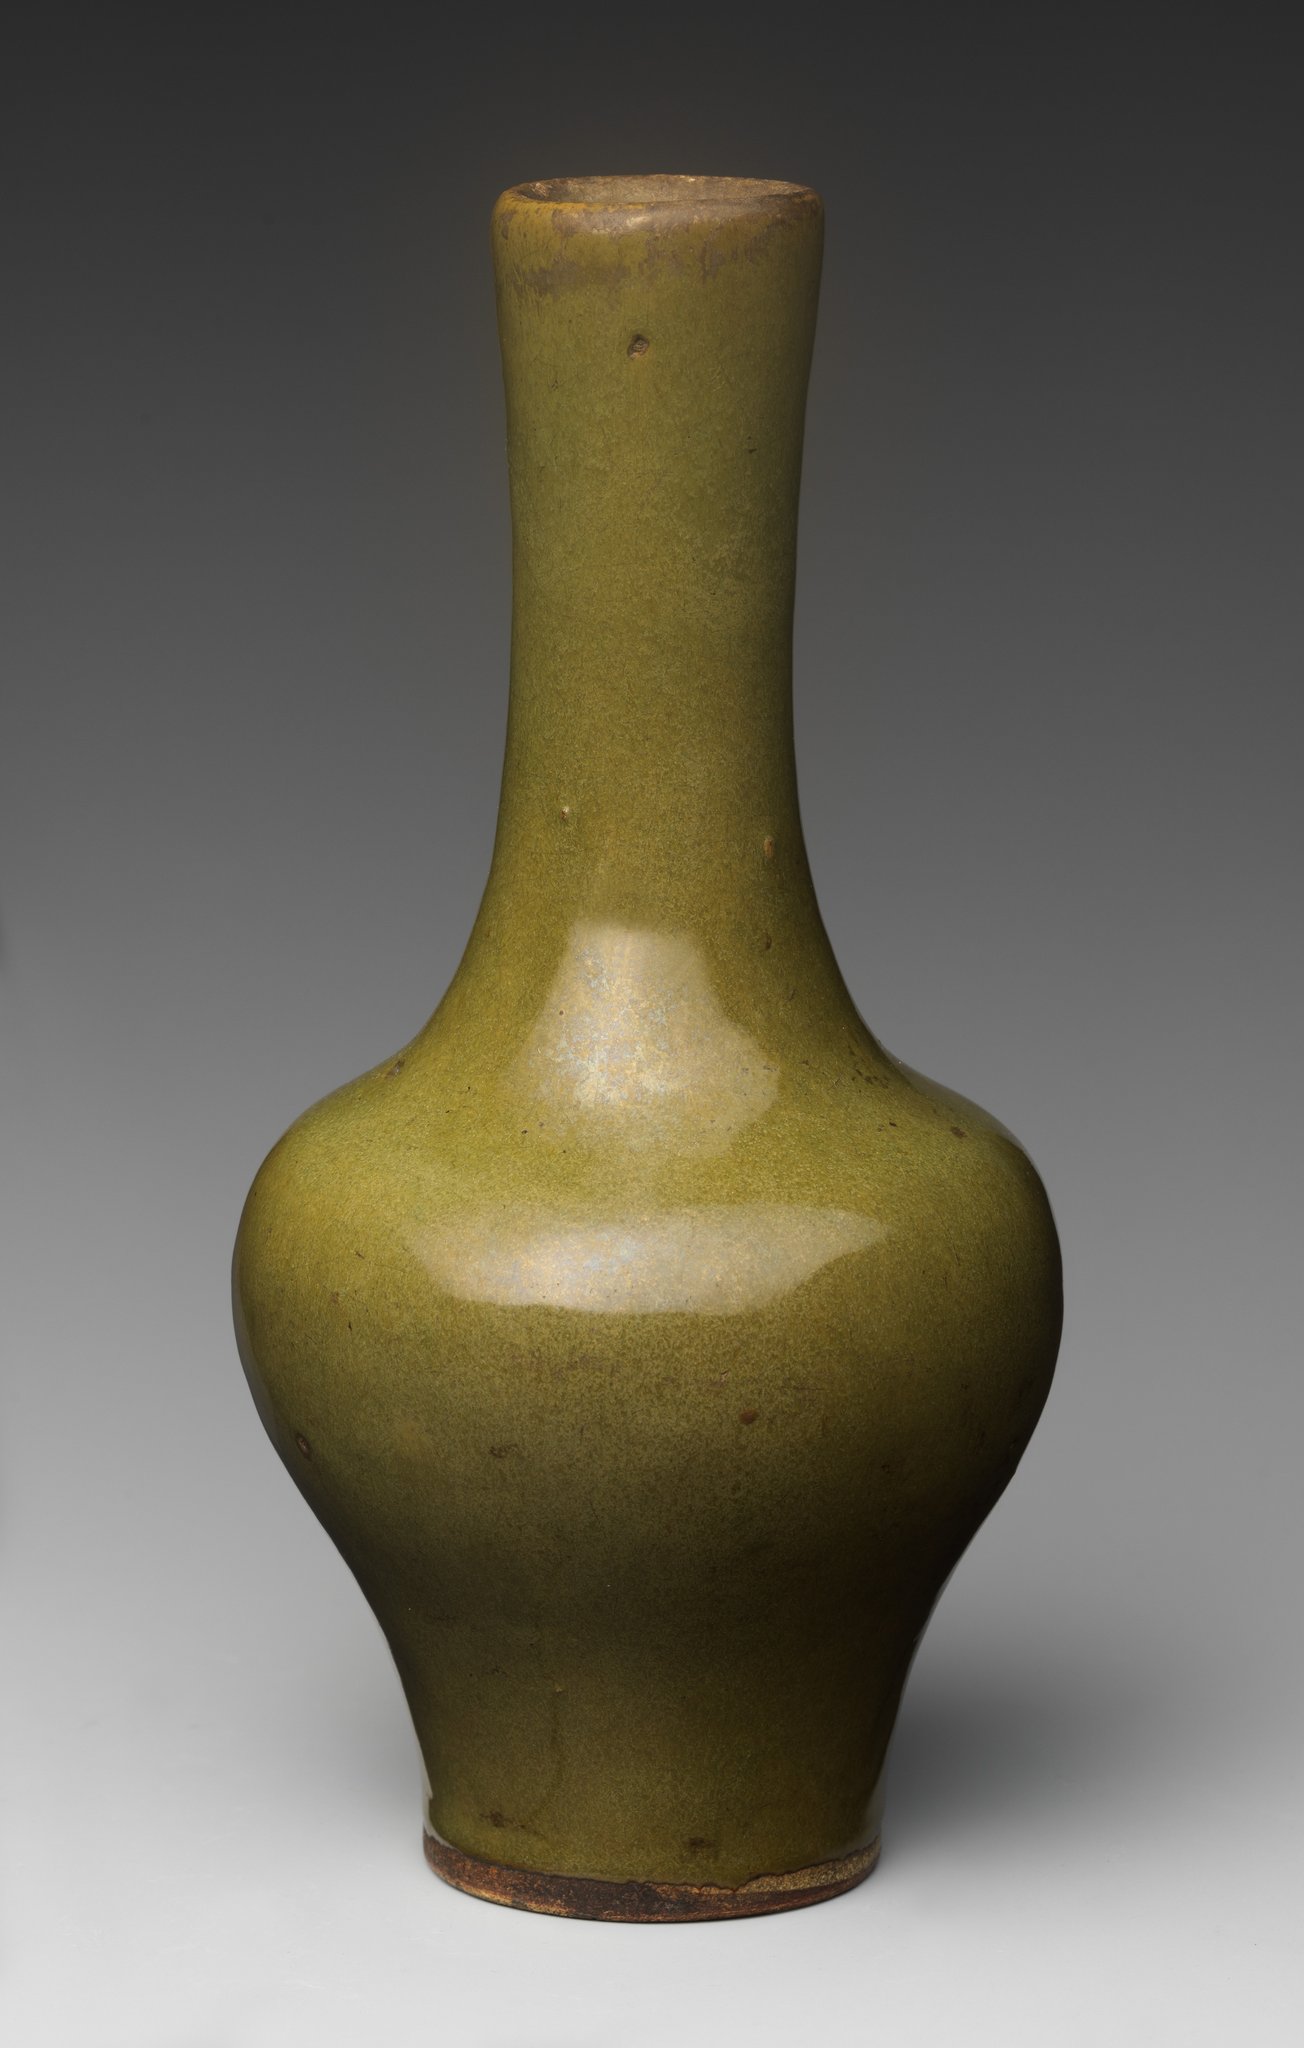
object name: vase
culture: japanese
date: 1701-1800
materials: clay, glaze